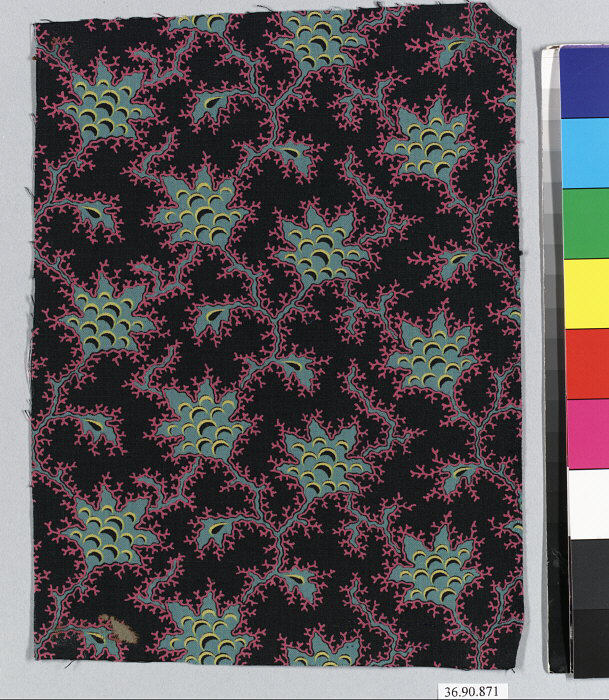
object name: piece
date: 1801-1900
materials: cotton